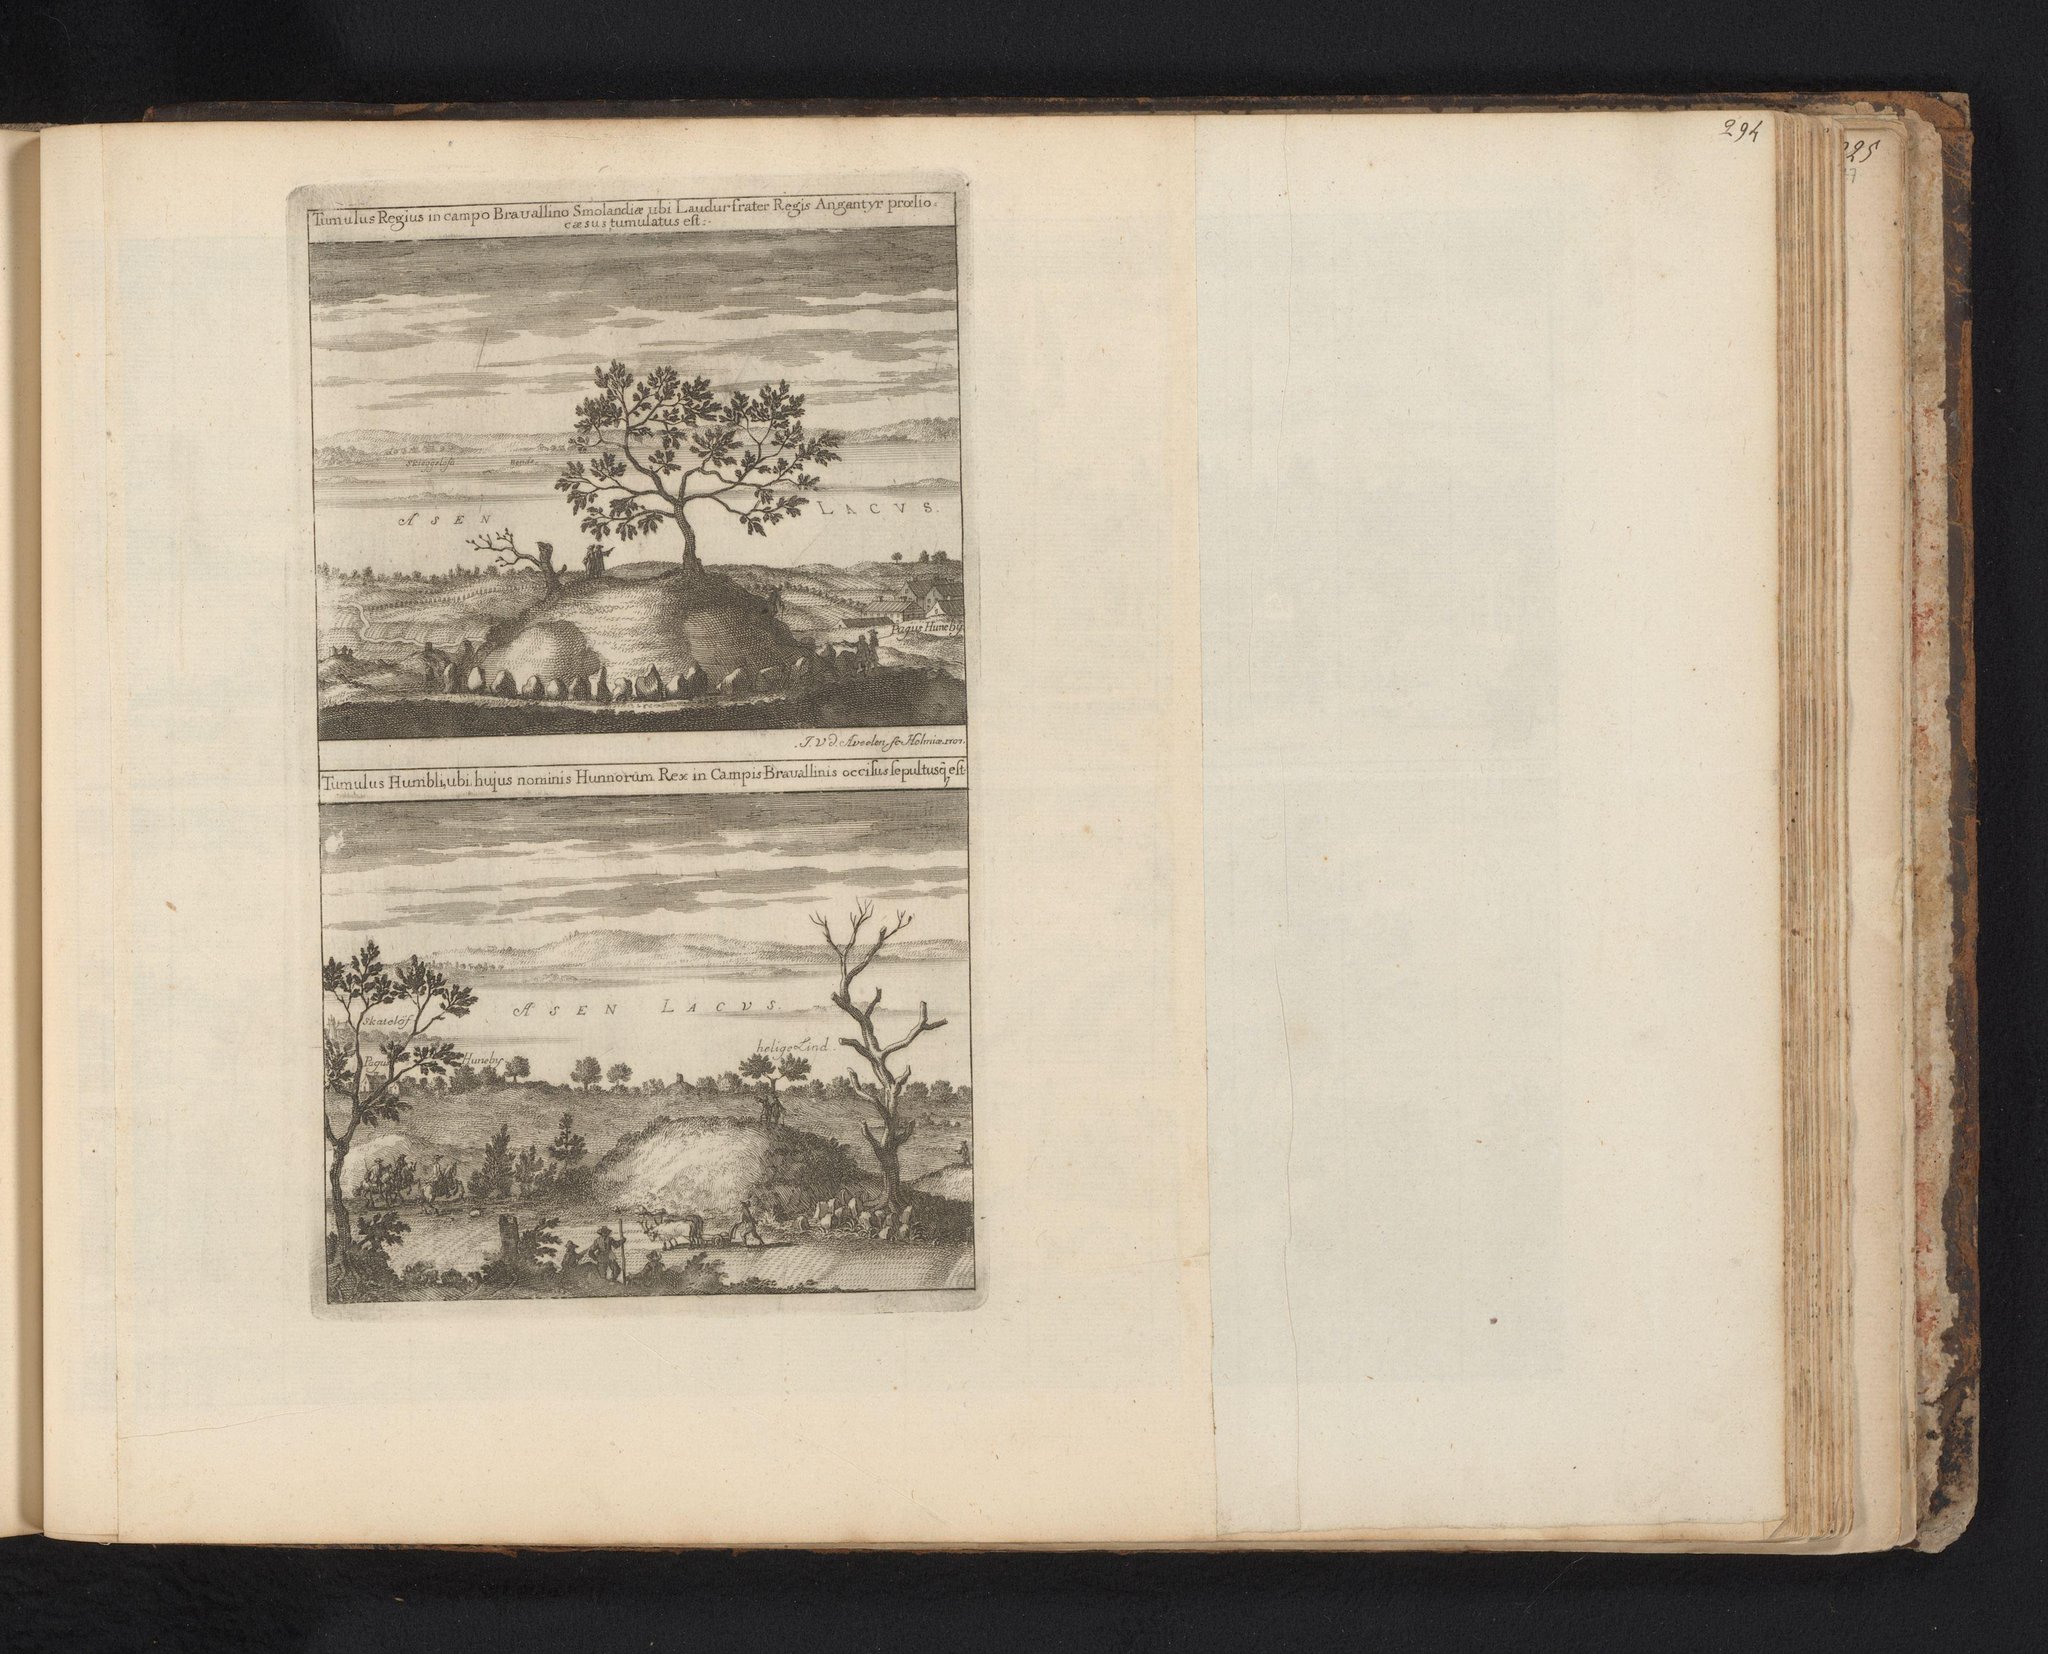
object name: album leaf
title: Tumulus Regius in campo Bravallino Smolandiæ ubi Laudur frater Regis Angantyr prælio caesus tumulatus est / Tumulus Humbli, ubi hujus nominis Hunnorum Rex in Campis Bravallinis occisus sepultusque est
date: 1707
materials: paper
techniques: etching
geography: stockholm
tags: grave, tomb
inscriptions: date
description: Kungliga Biblioteket, 'Suecia': http://www.kb.se/samlingarna/Kartor-bilder/Suecia-antiqua/ (geraadpleegd november 2016).